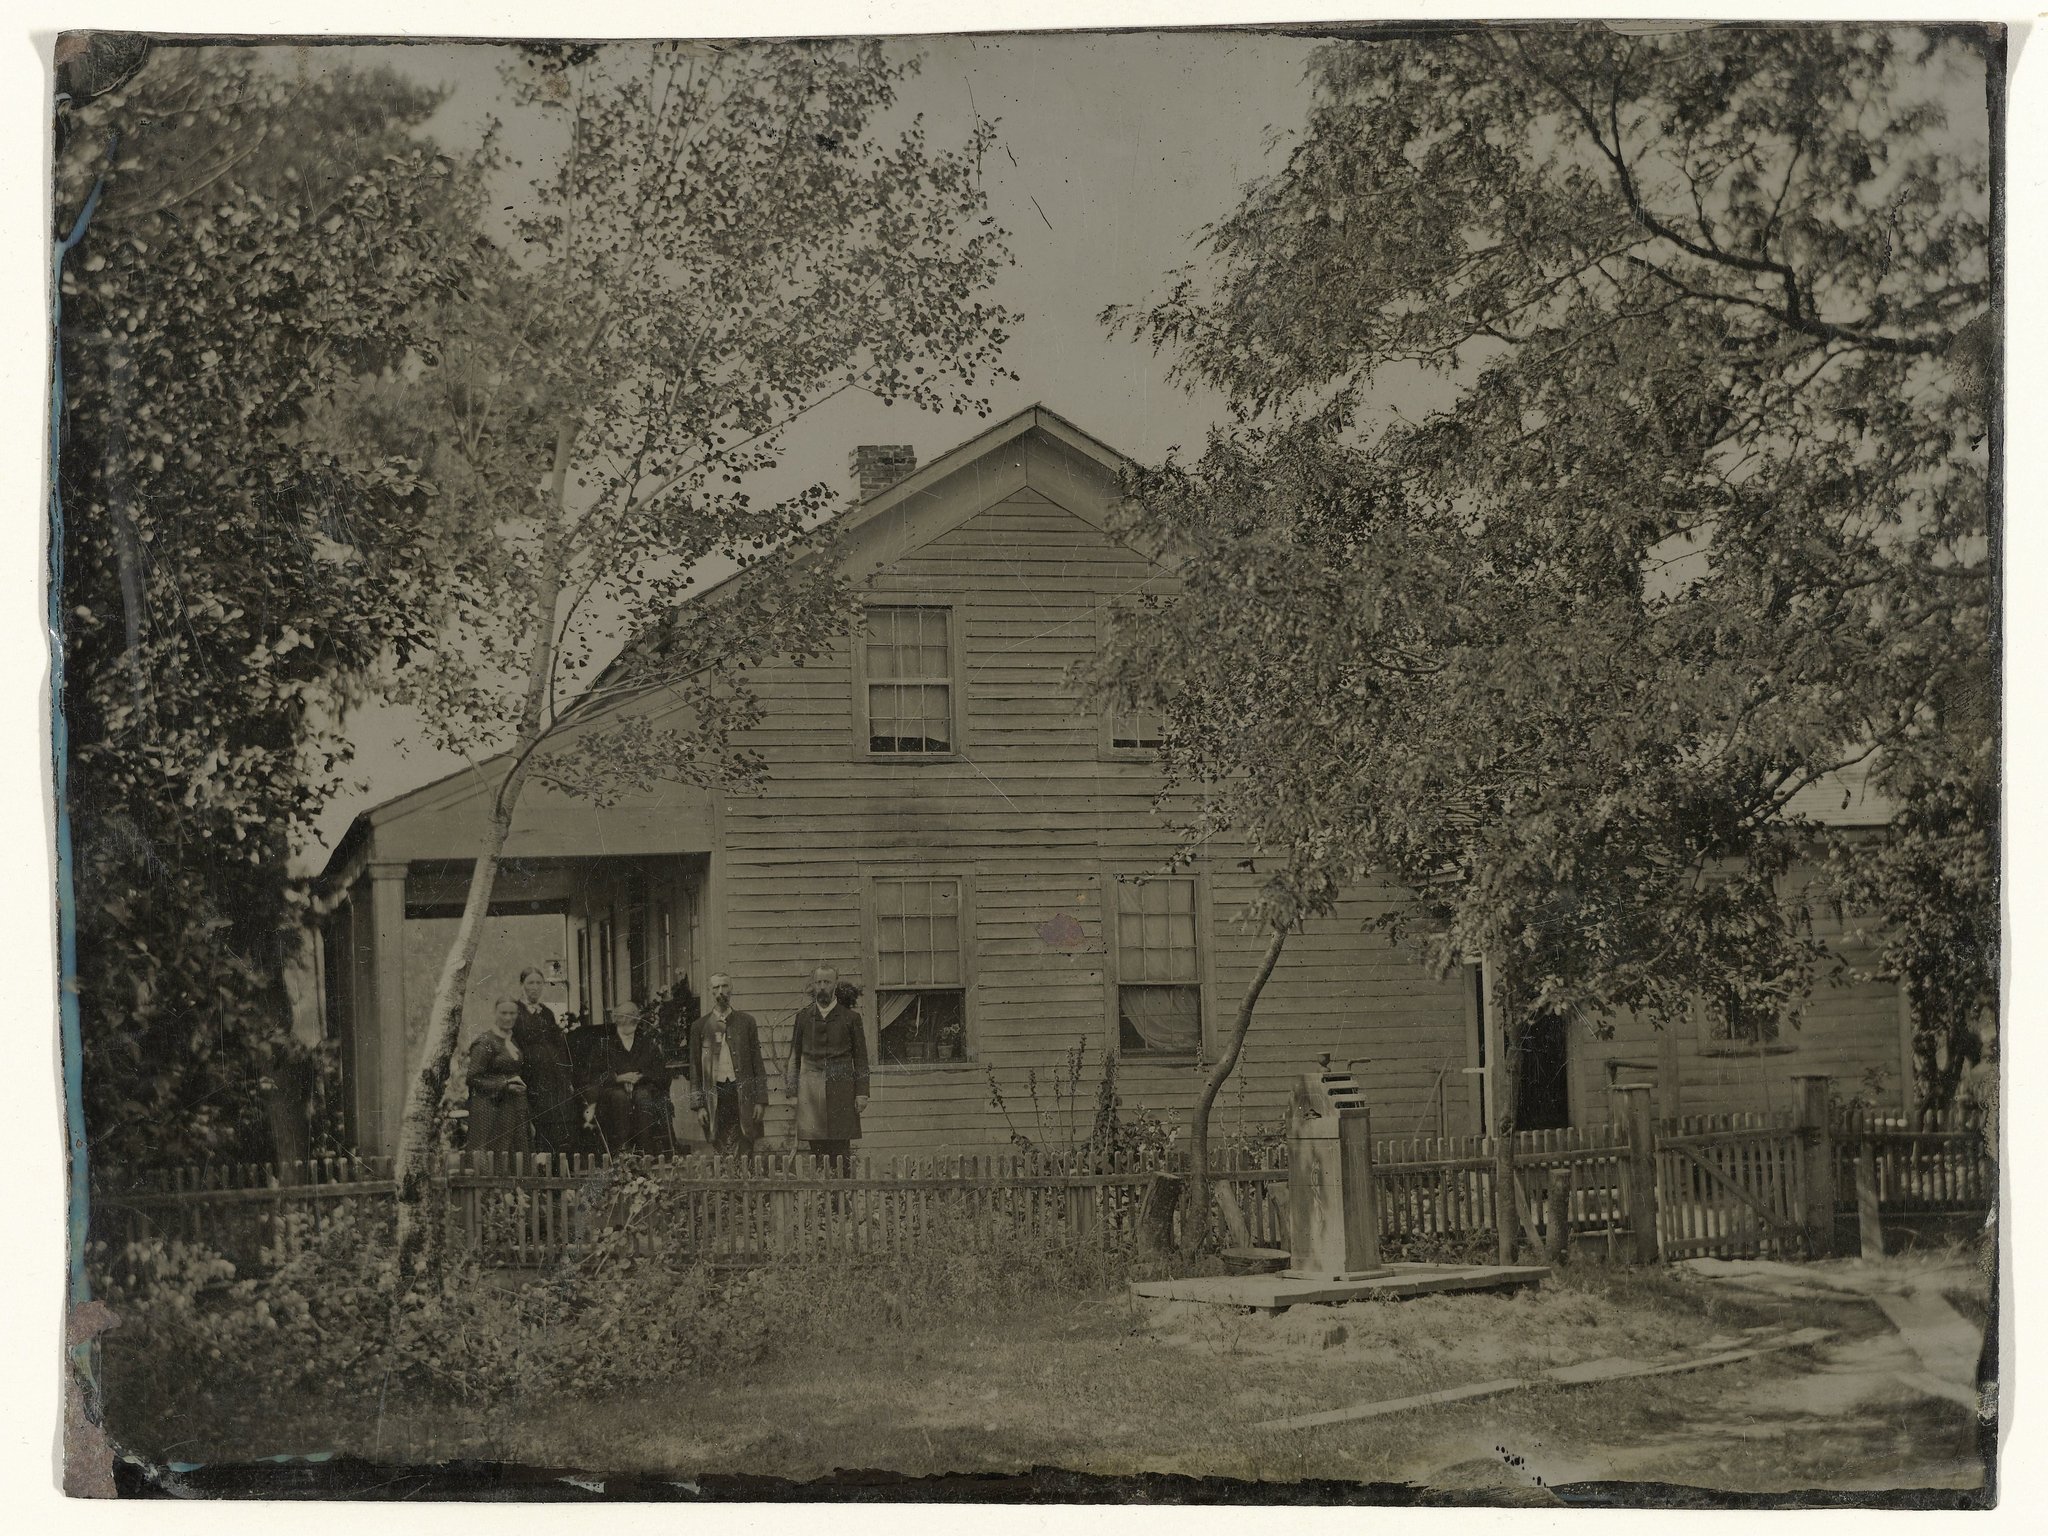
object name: photograph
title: Bewoners voor een houten huis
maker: Anonymous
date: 1860-1900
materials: metal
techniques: ferrotyping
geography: united states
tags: rural housing, e.g. country-house, villa, cottage, united states of america